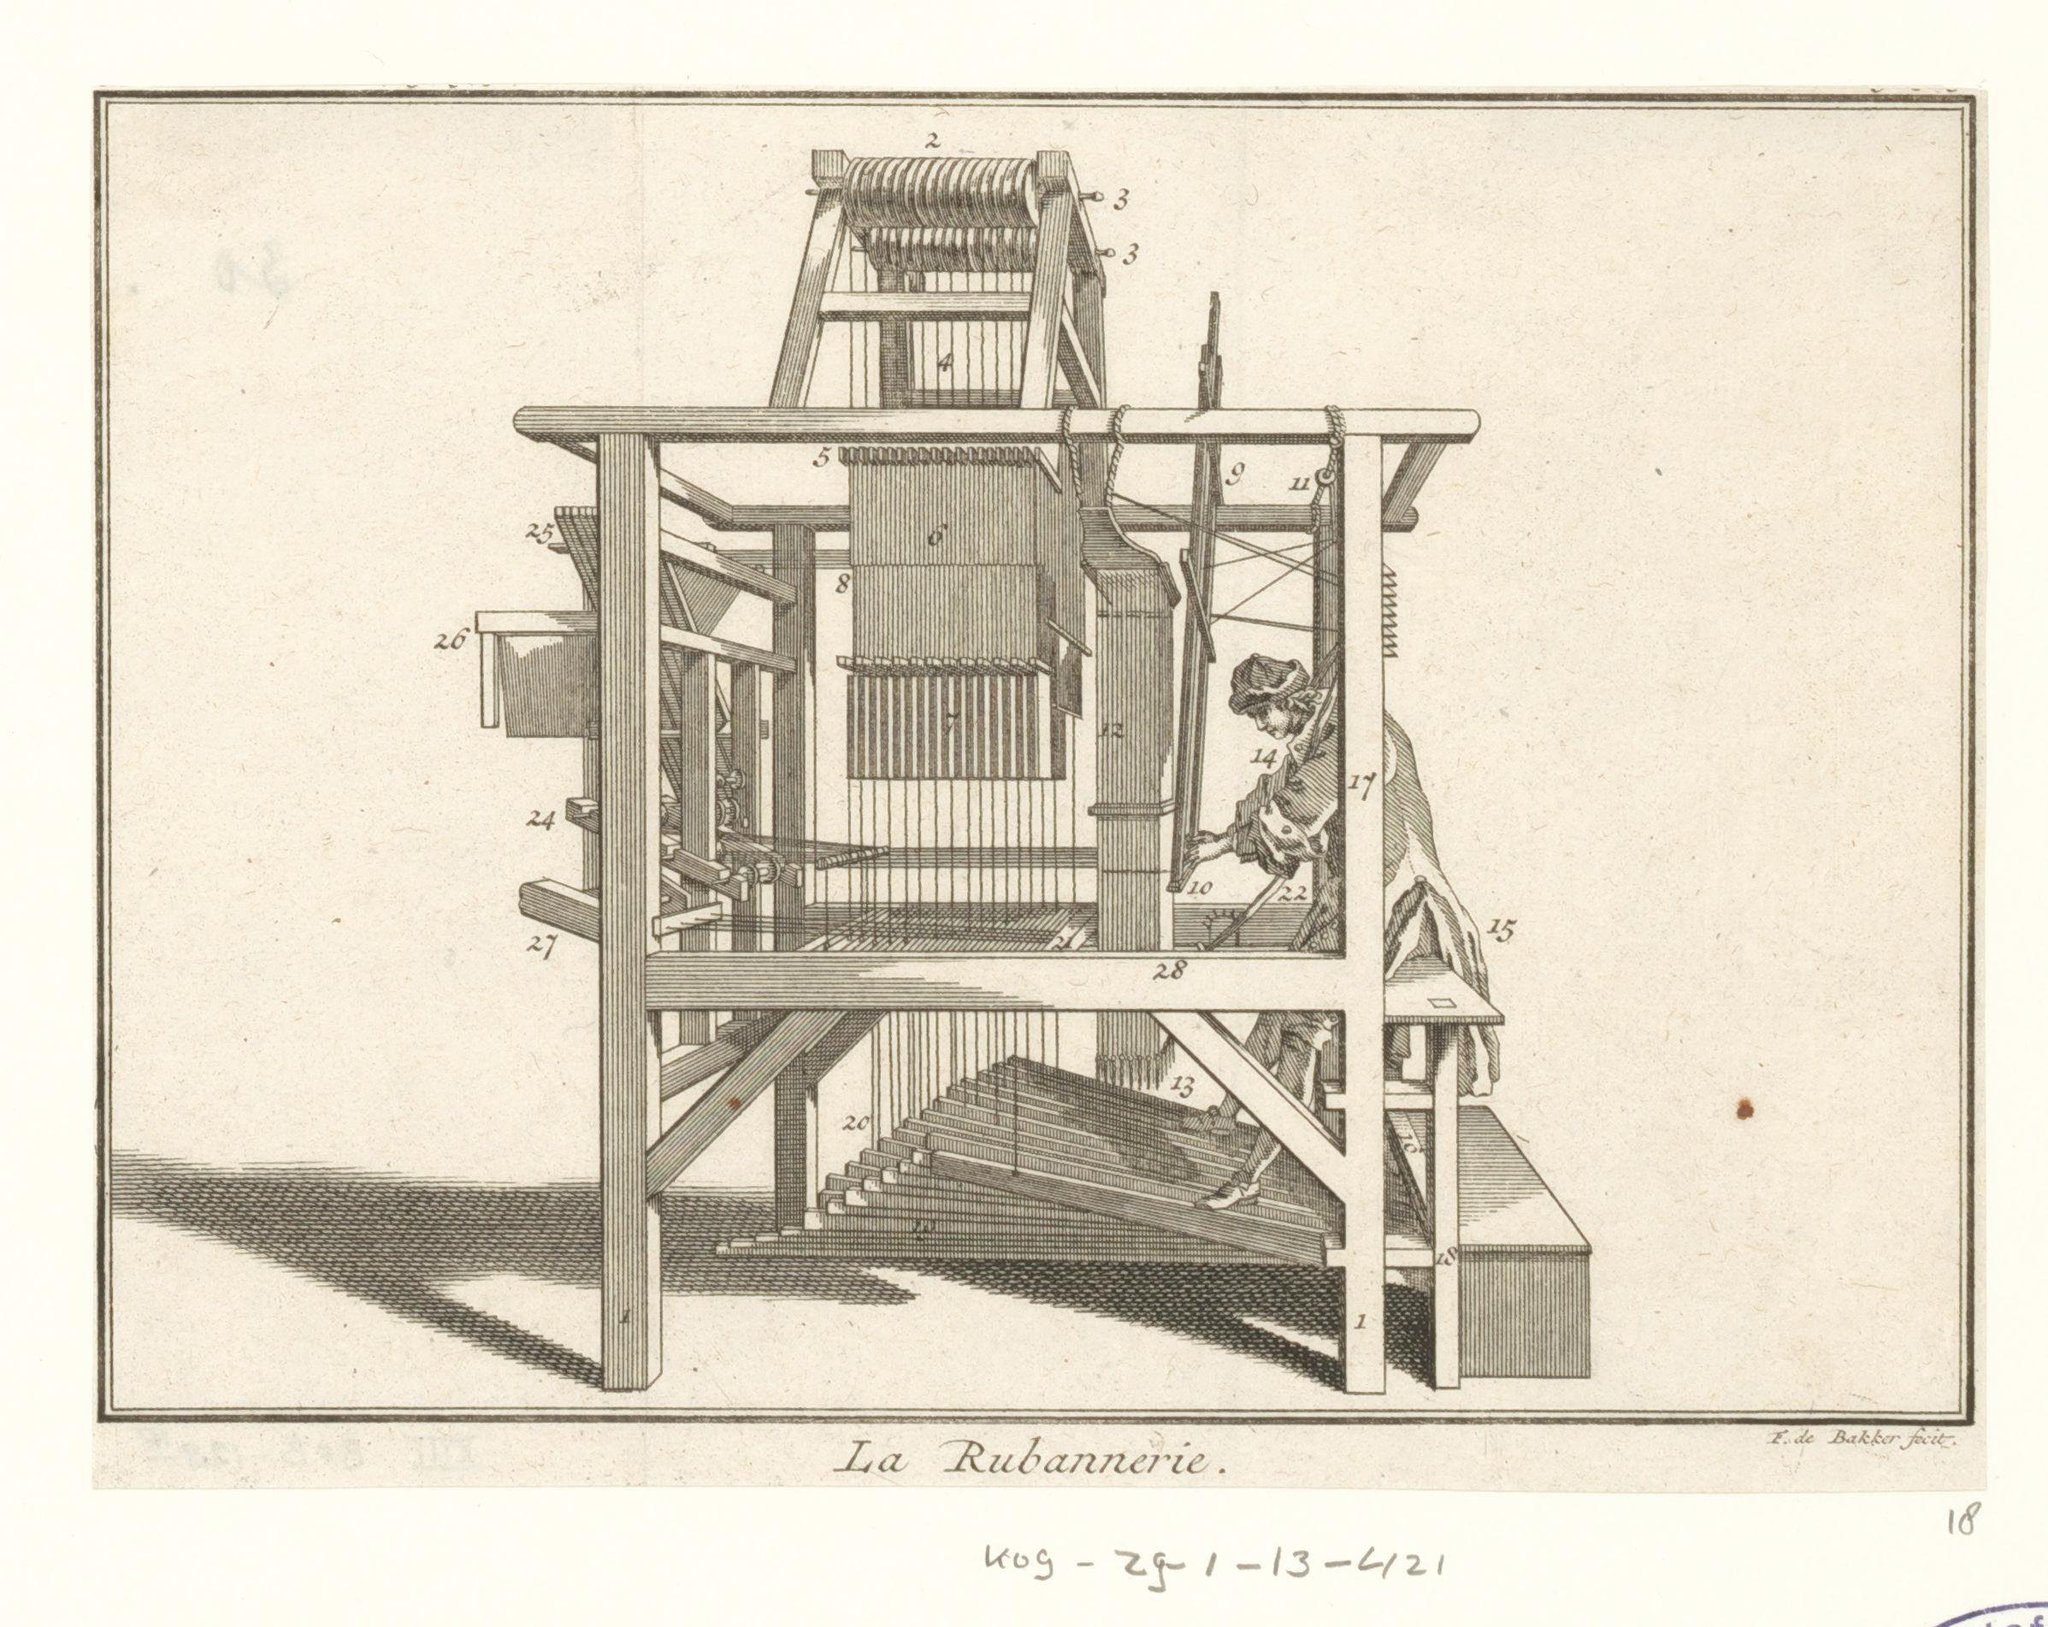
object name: print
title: Lintwerker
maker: frans de bakker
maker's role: print maker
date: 1747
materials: paper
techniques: engraving, etching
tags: tapestry weaver, gobelin maker, textile industry and clothing industry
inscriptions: stamp, collector's mark: Lugt 1641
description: Prent mogelijk uit: Noël-Antoine Pluche. Schouwtoneel der natuur, of Samenspraaken over de Bysonderheden der natuurlyke histori (...). [Vertaald uit het Frans door] Pieter le Clercq. 14 dln. Amsterdam: Salomon Schouten, 1737-1749, dl. 12, na p. 372.